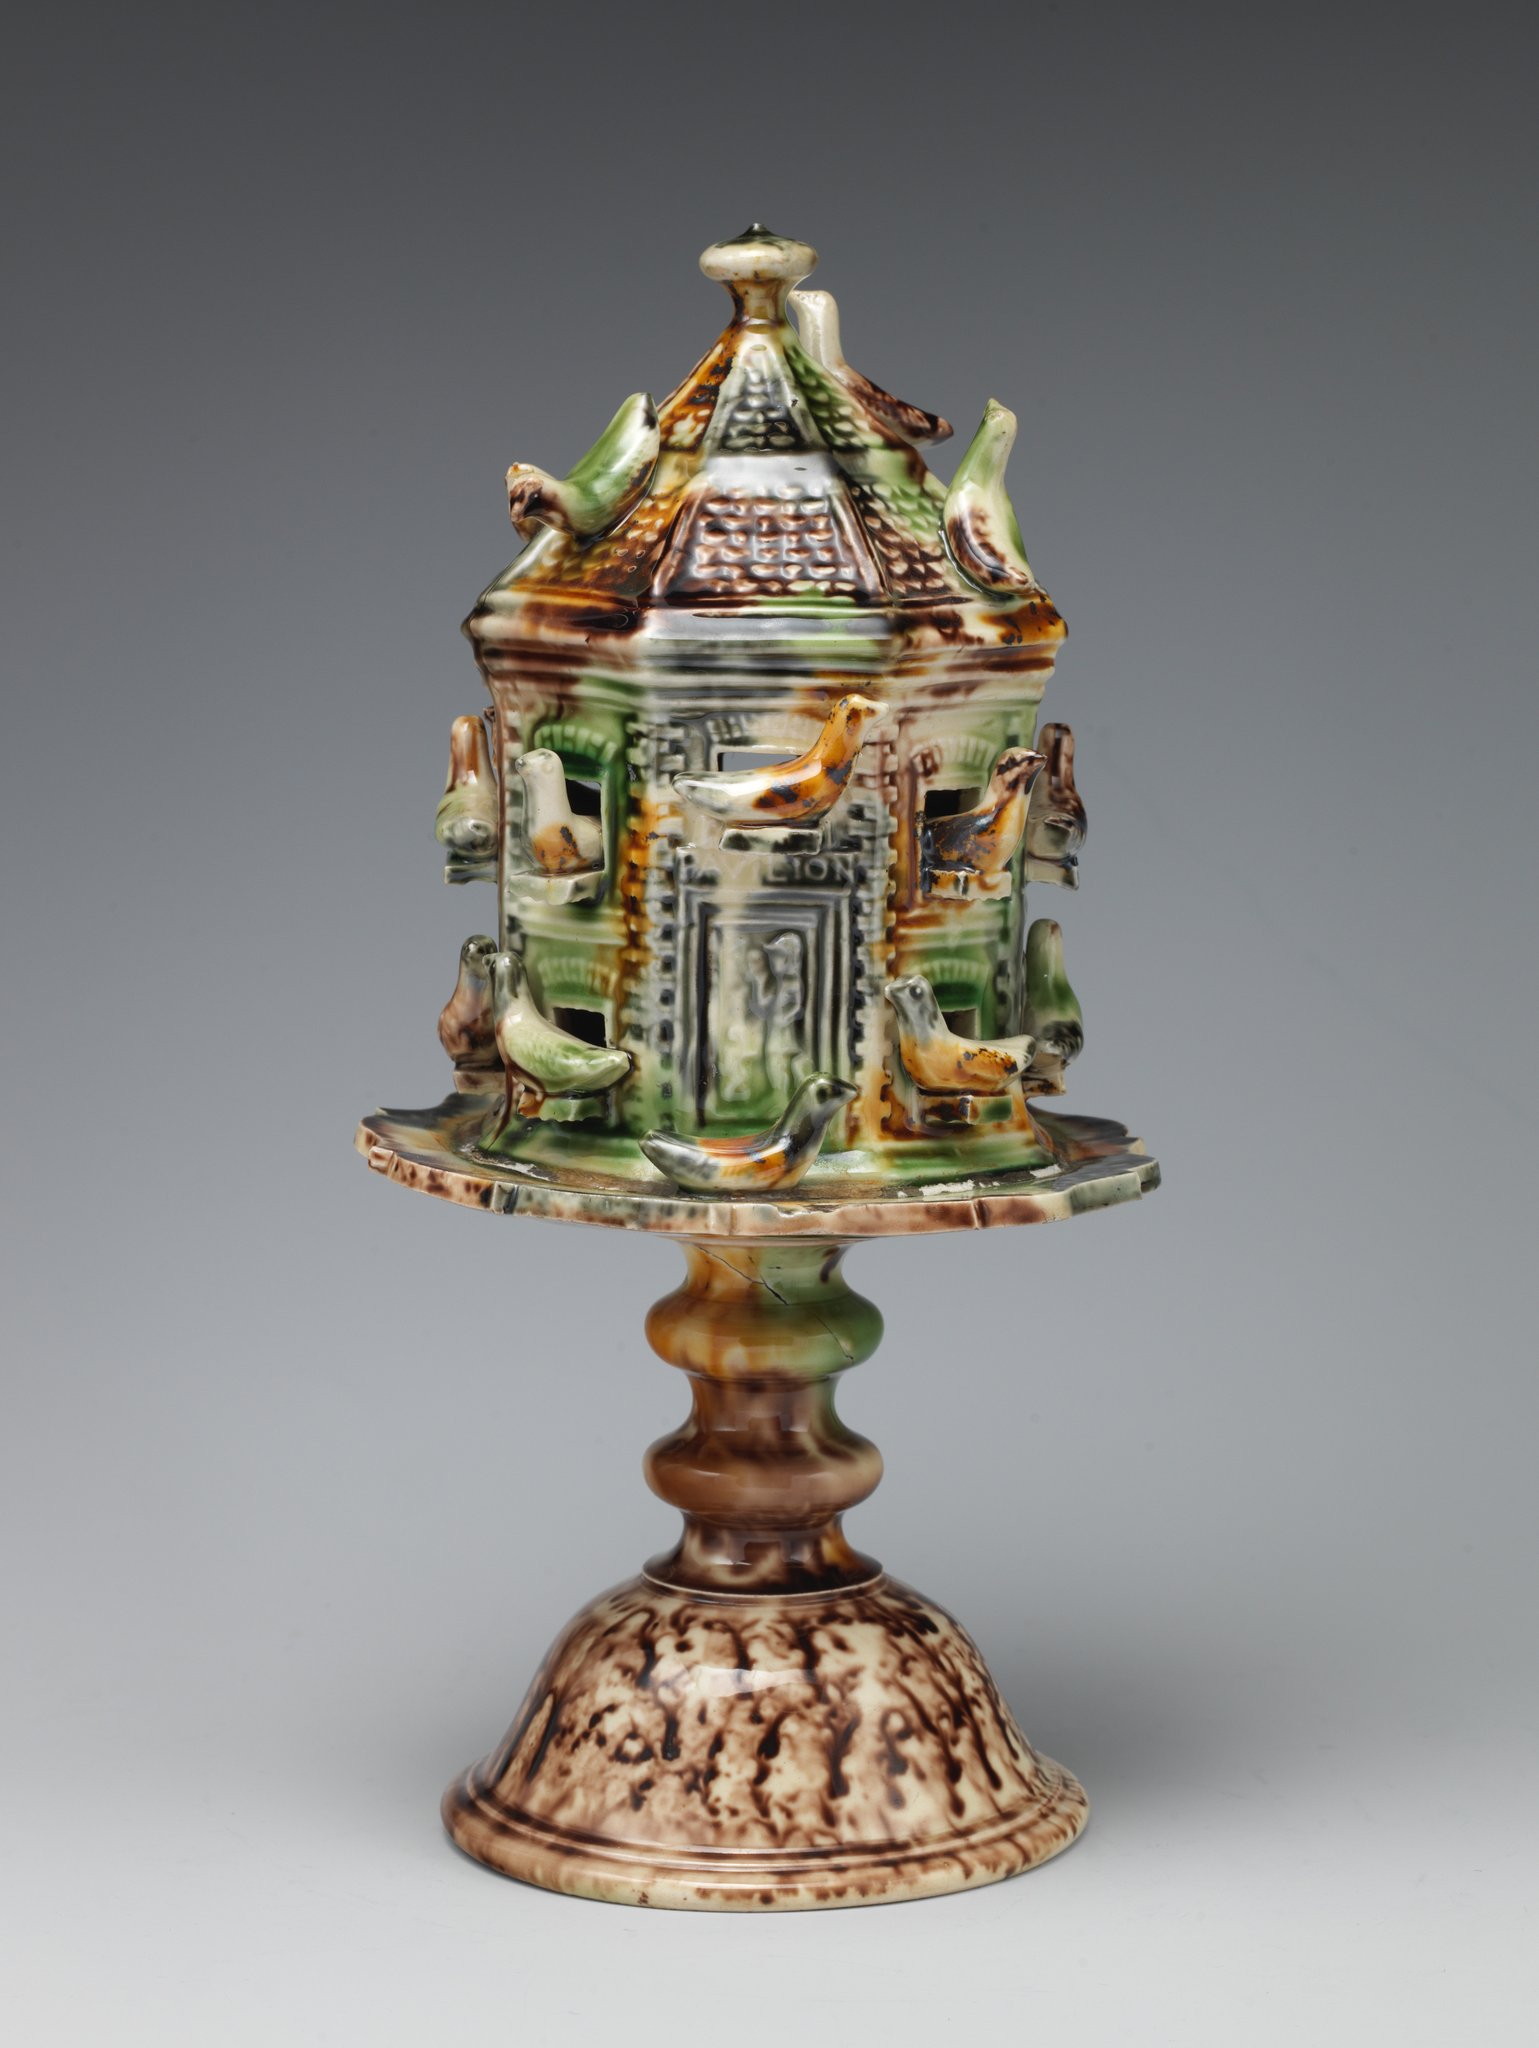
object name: dovecote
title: Dovecote (one of a pair)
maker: whieldon type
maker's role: maker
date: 1750-1760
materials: earthenware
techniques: glazing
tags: birds